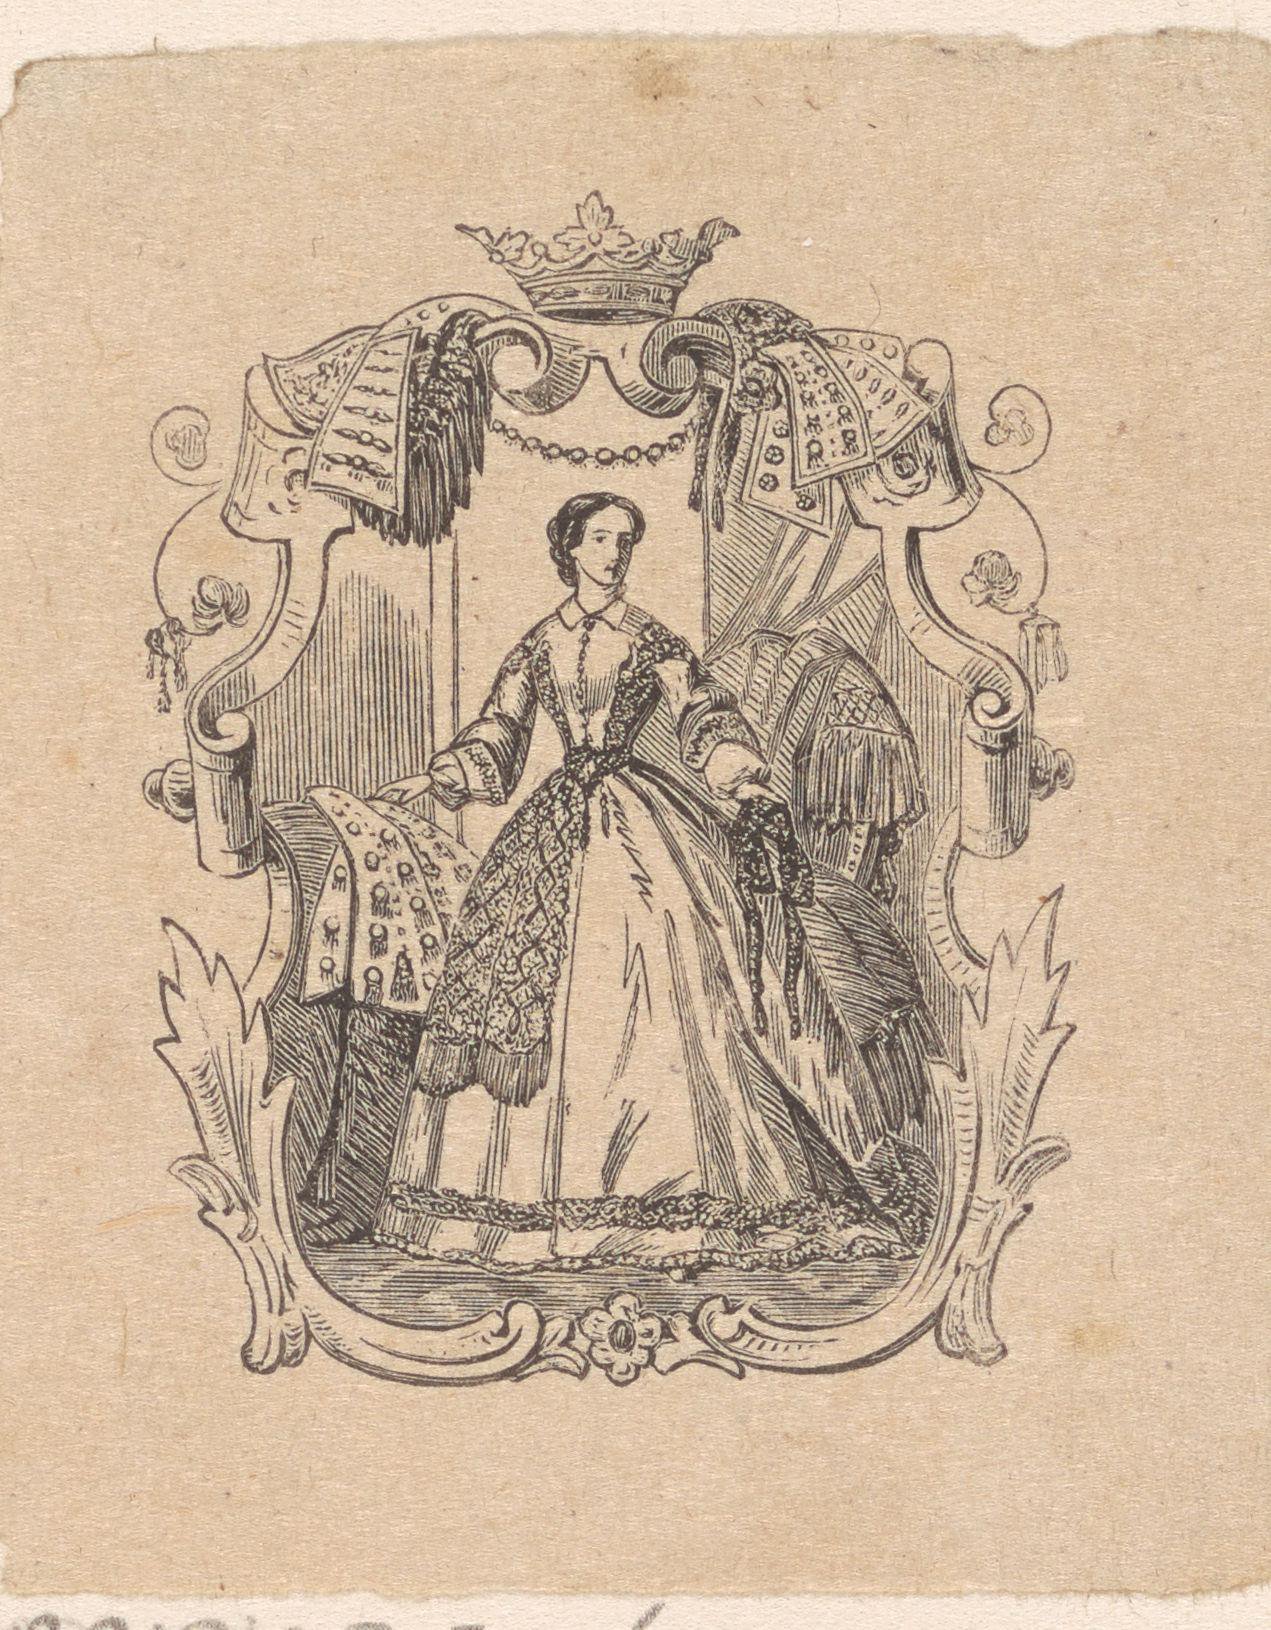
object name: print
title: Vrouw in een geornamenteerde omlijsting met een kroon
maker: isaac weissenbruch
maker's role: print maker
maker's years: 1826-1912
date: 1836-1912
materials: paper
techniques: engraving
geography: netherlands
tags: crown (symbol of sovereignty), adult woman (+ standing)